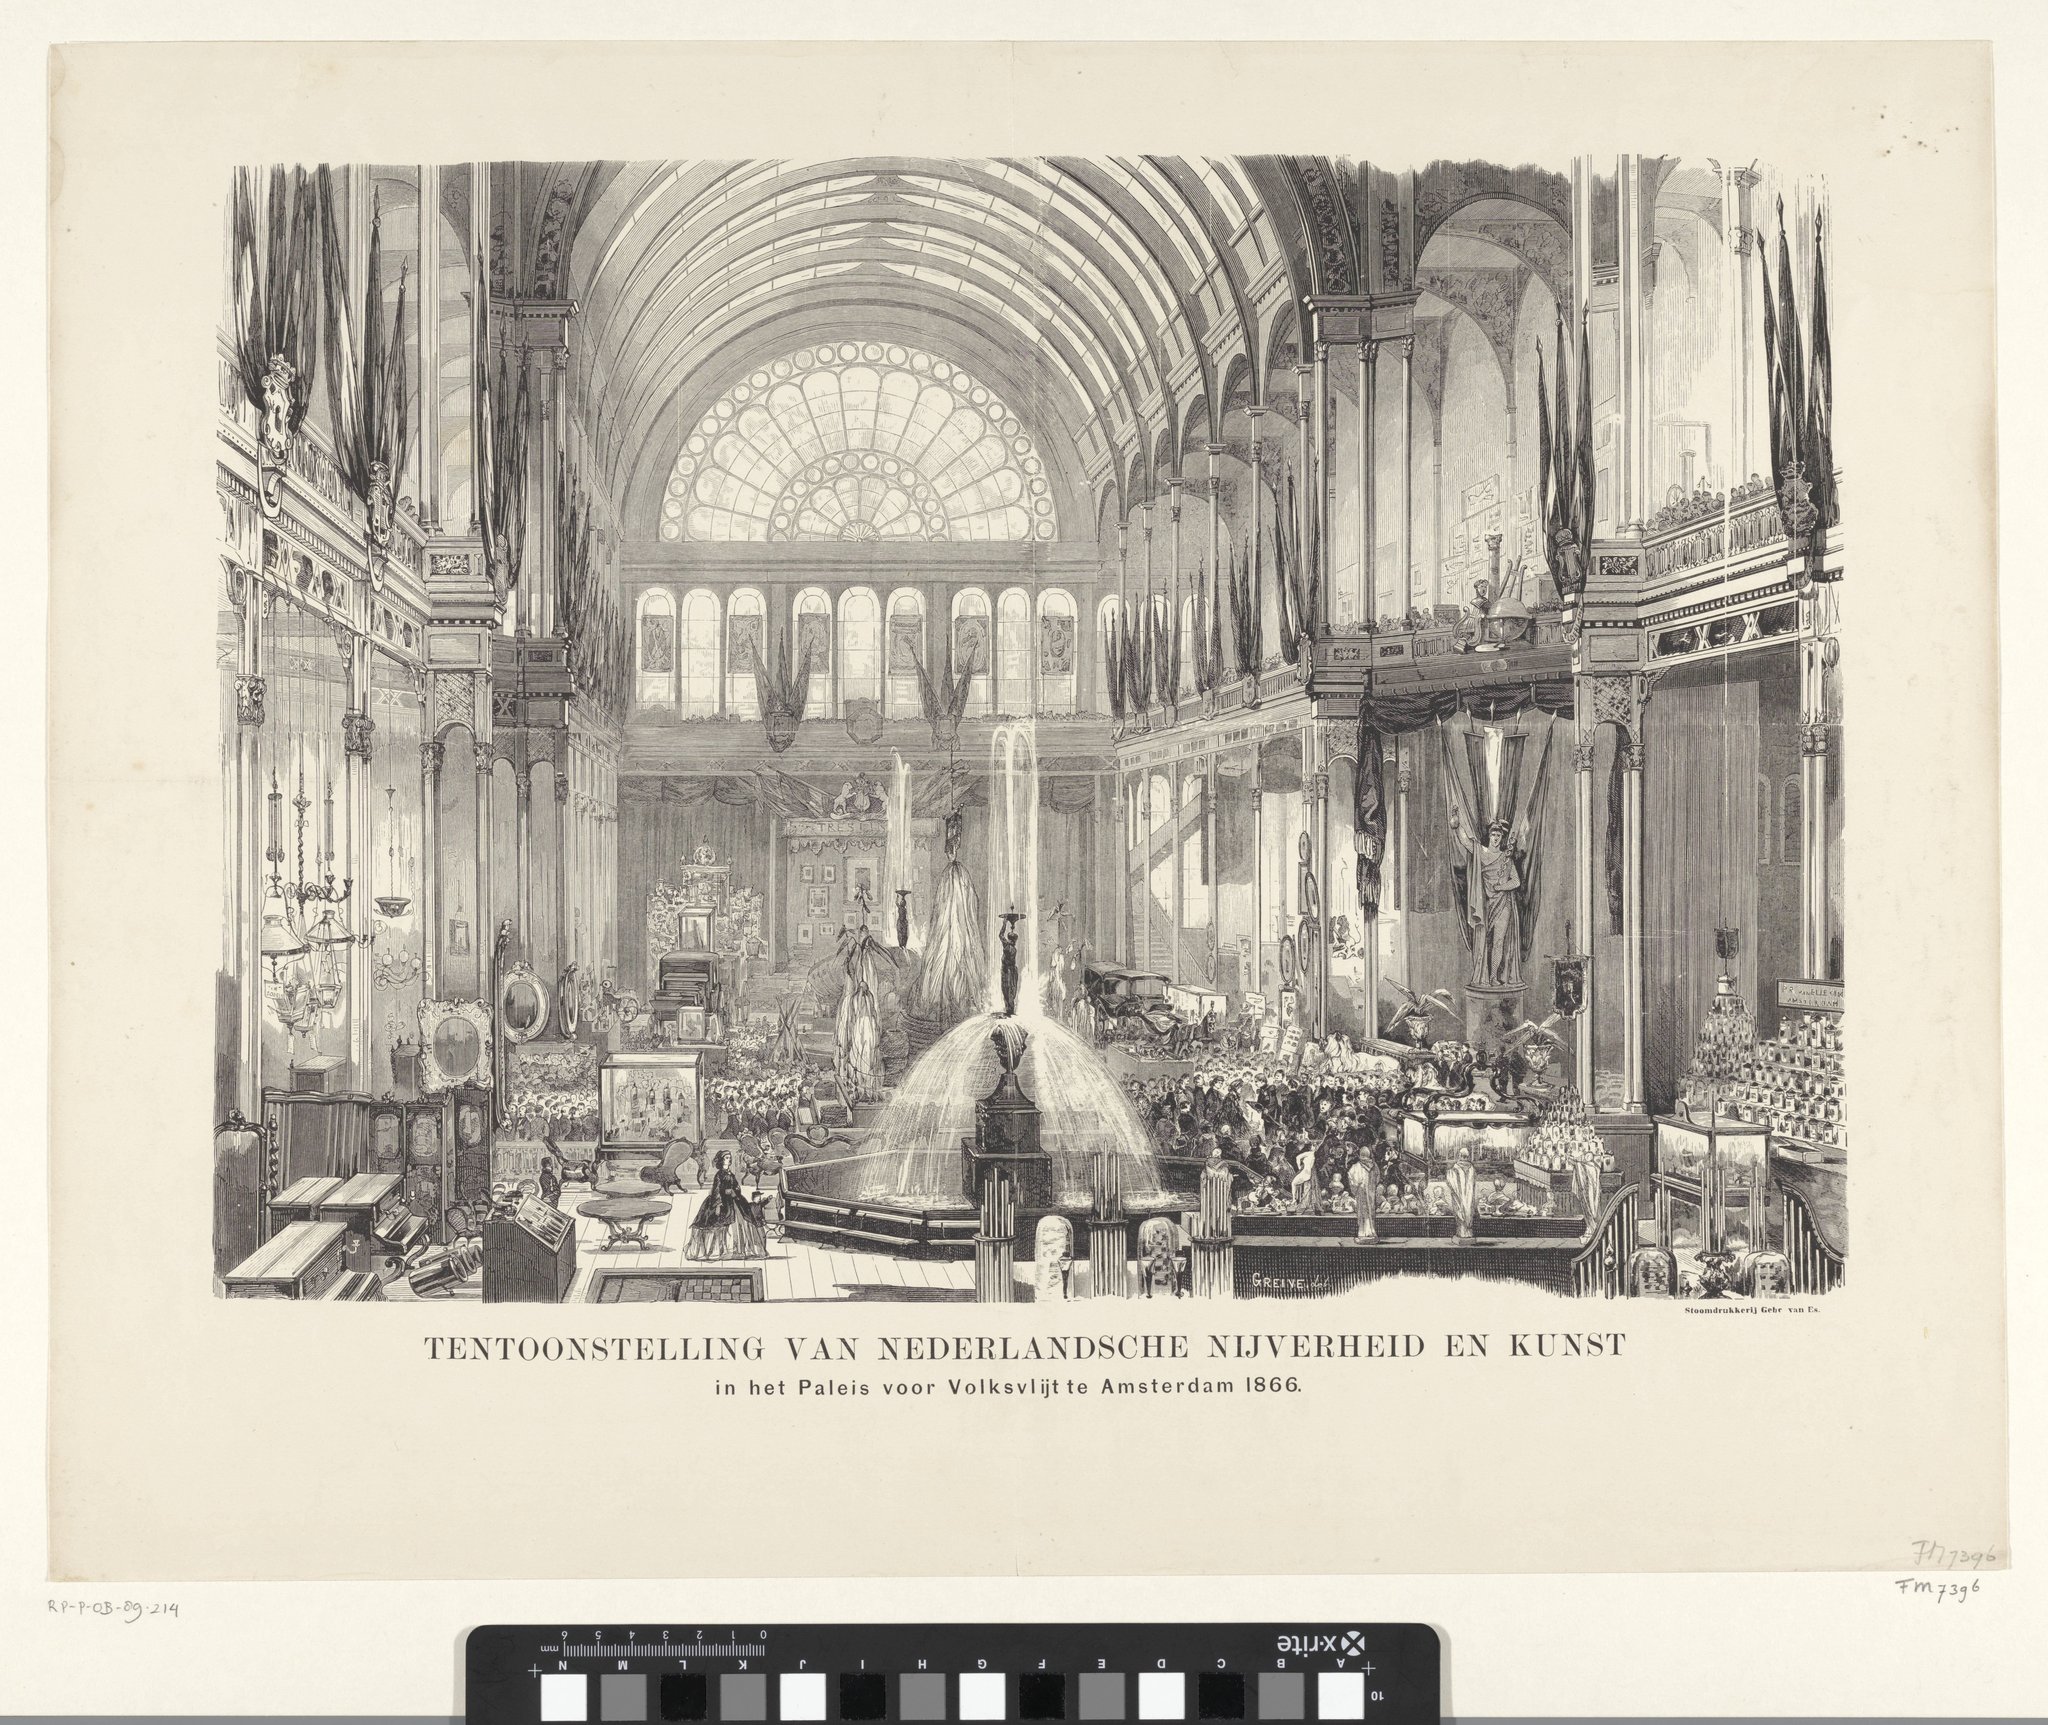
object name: print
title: Tentoonstelling van Nederlandsche Nijverheid en Kunst in het Paleis voor Volksvlijt te Amsterdam 1866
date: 1866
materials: paper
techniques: engraving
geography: amsterdam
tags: (annual) fair, trade fair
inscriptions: collector's mark: Lugt 2228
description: Gezicht in het interieur van het Paleis voor Volksvlijt tijdens de Algemeene Tentoonstelling van Nederlandsche Nijverheid en Kunst te Amsterdam, juni-oktober 1866. Mogelijk het moment van de opening op 21 juni door Prins Frederik of tijdens een bezoek van koningin Sophia; een groot gezelschap heeft zich verzameld achter de centrale fontein, rechts een vrouw tegenover een hoogwaardigheidsbekleder.